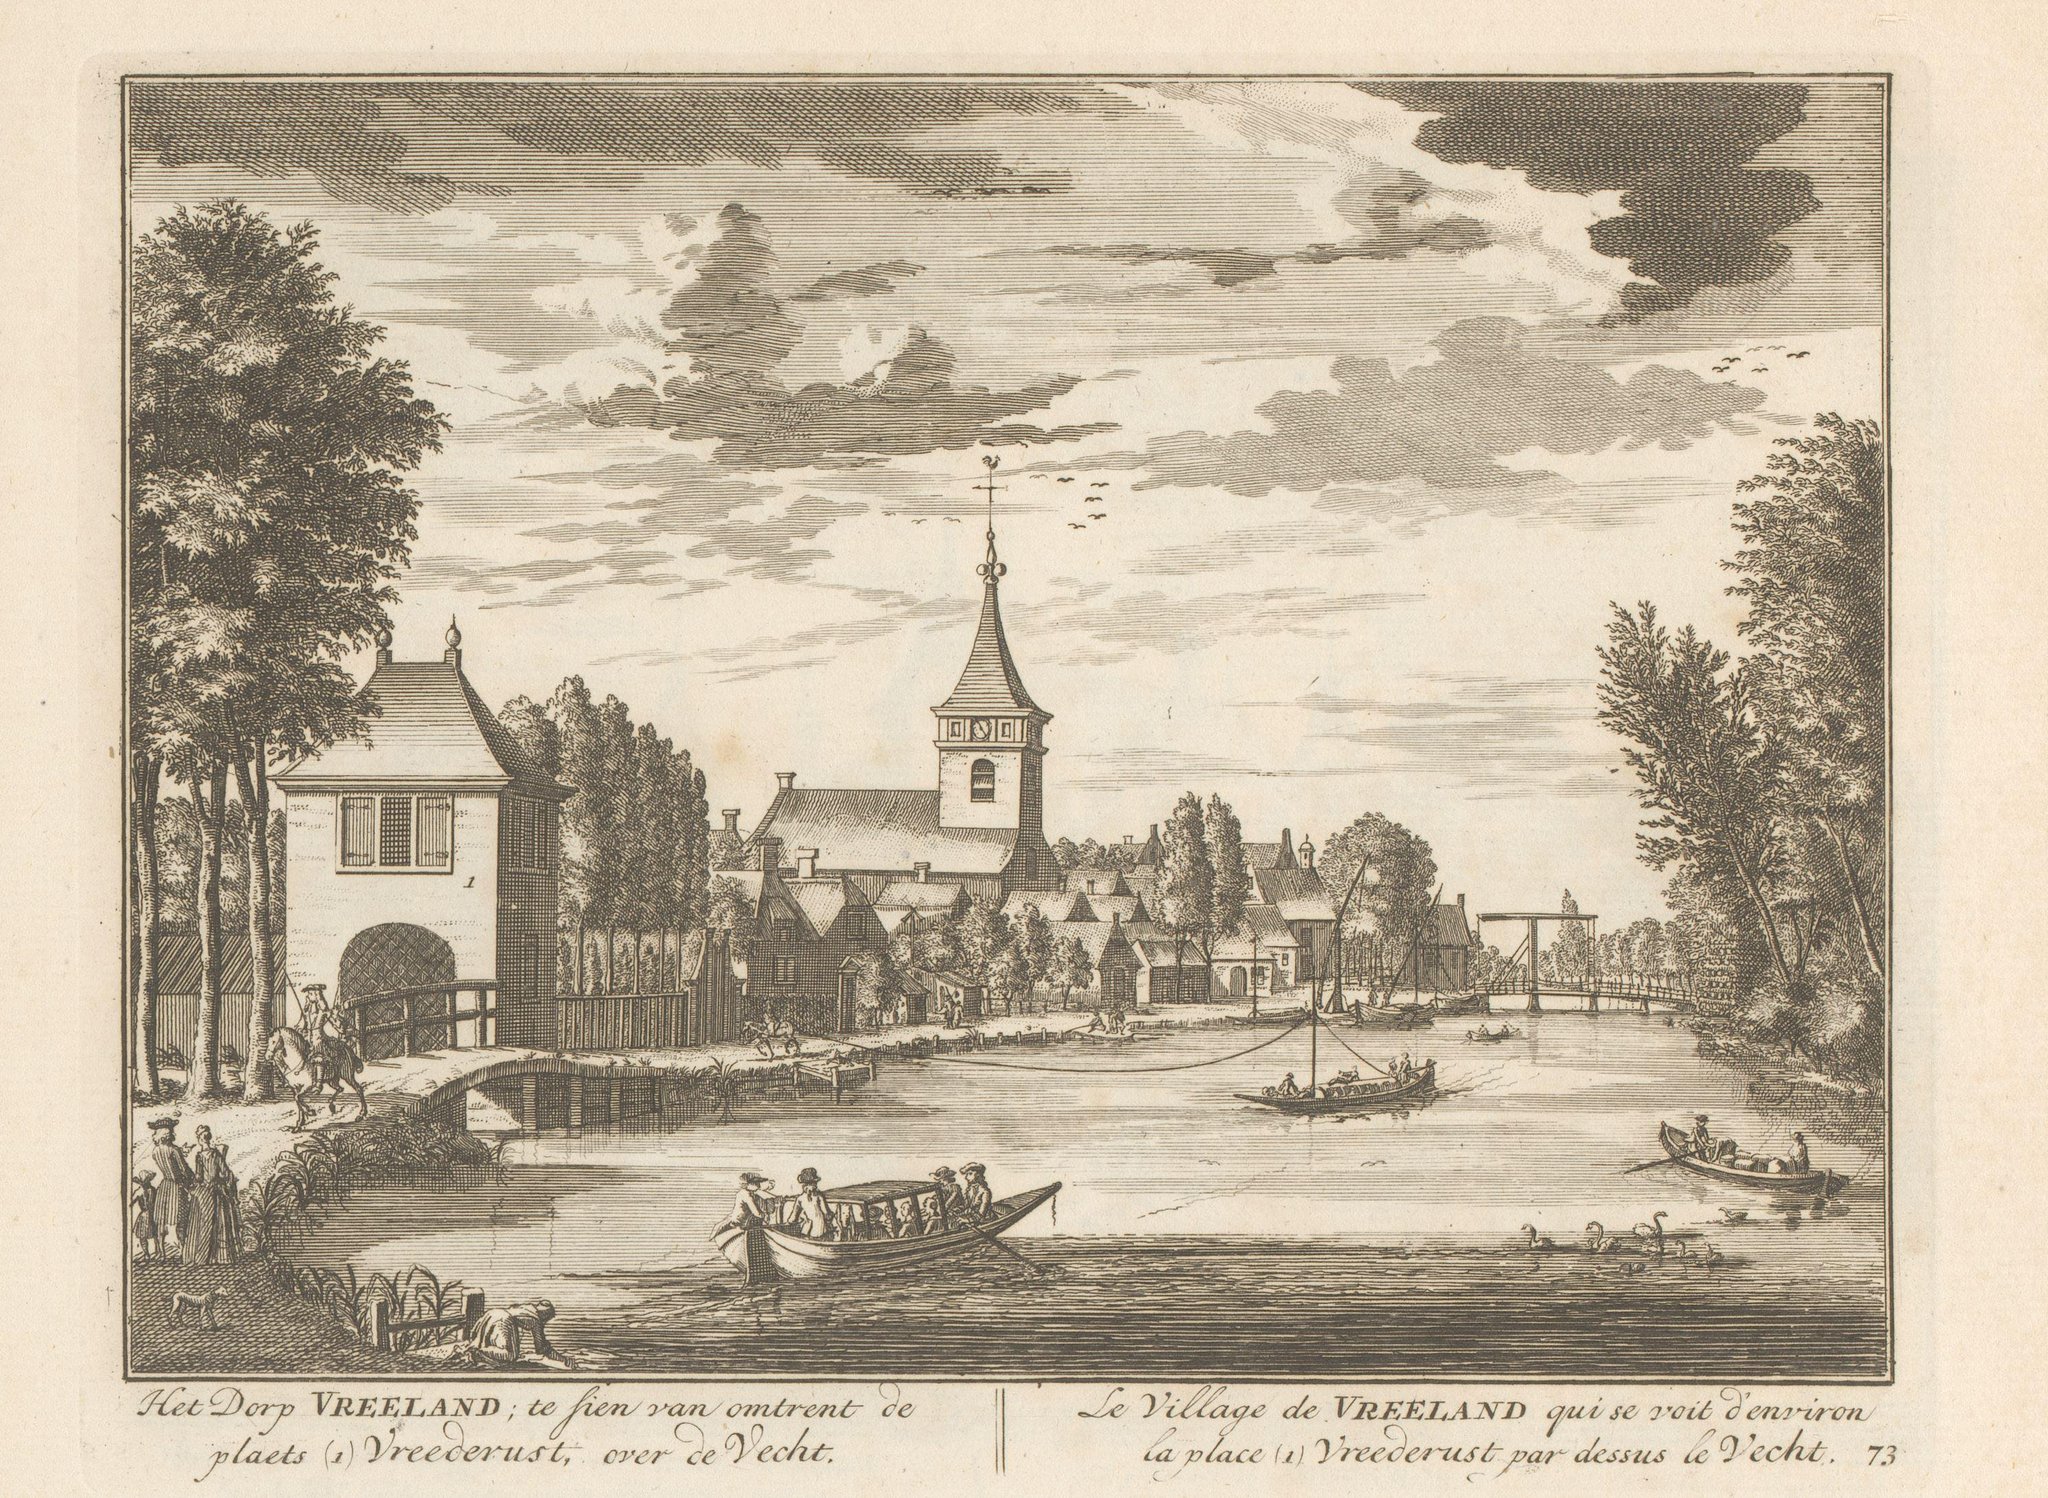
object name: print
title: Het Dorp Vreeland; te sien van omtrent de plaets (1) Vreederust, over de Vecht / Le Village de Vreeland qui se voit d'environ la place (1) Vreederust par dessus le Vecht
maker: daniël stopendaal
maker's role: print maker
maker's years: 1672-1726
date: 1790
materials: paper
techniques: engraving, etching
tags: prospect of village, silhouette of village, river (+ landscape with figures, staffage), country-house, vecht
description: Prent gebruikt in: Leth, Andries de. De zegepraalende Vecht, vertoonende verscheidene gesichten van lustplaatsen, heeren huysen en dorpen, beginnende van Uitrecht en met Muyden besluytende (...). Amsterdam: Weduwe Nicolaus Visscher, 1719. Prent ook gebruikt in: Brouërius van Nidek, Matthaeus. De Vechtstroom, van Utrecht tot Muiden (...). Amsterdam: H. Gartman, W. Vermandel en J.W. Smit, 1790.